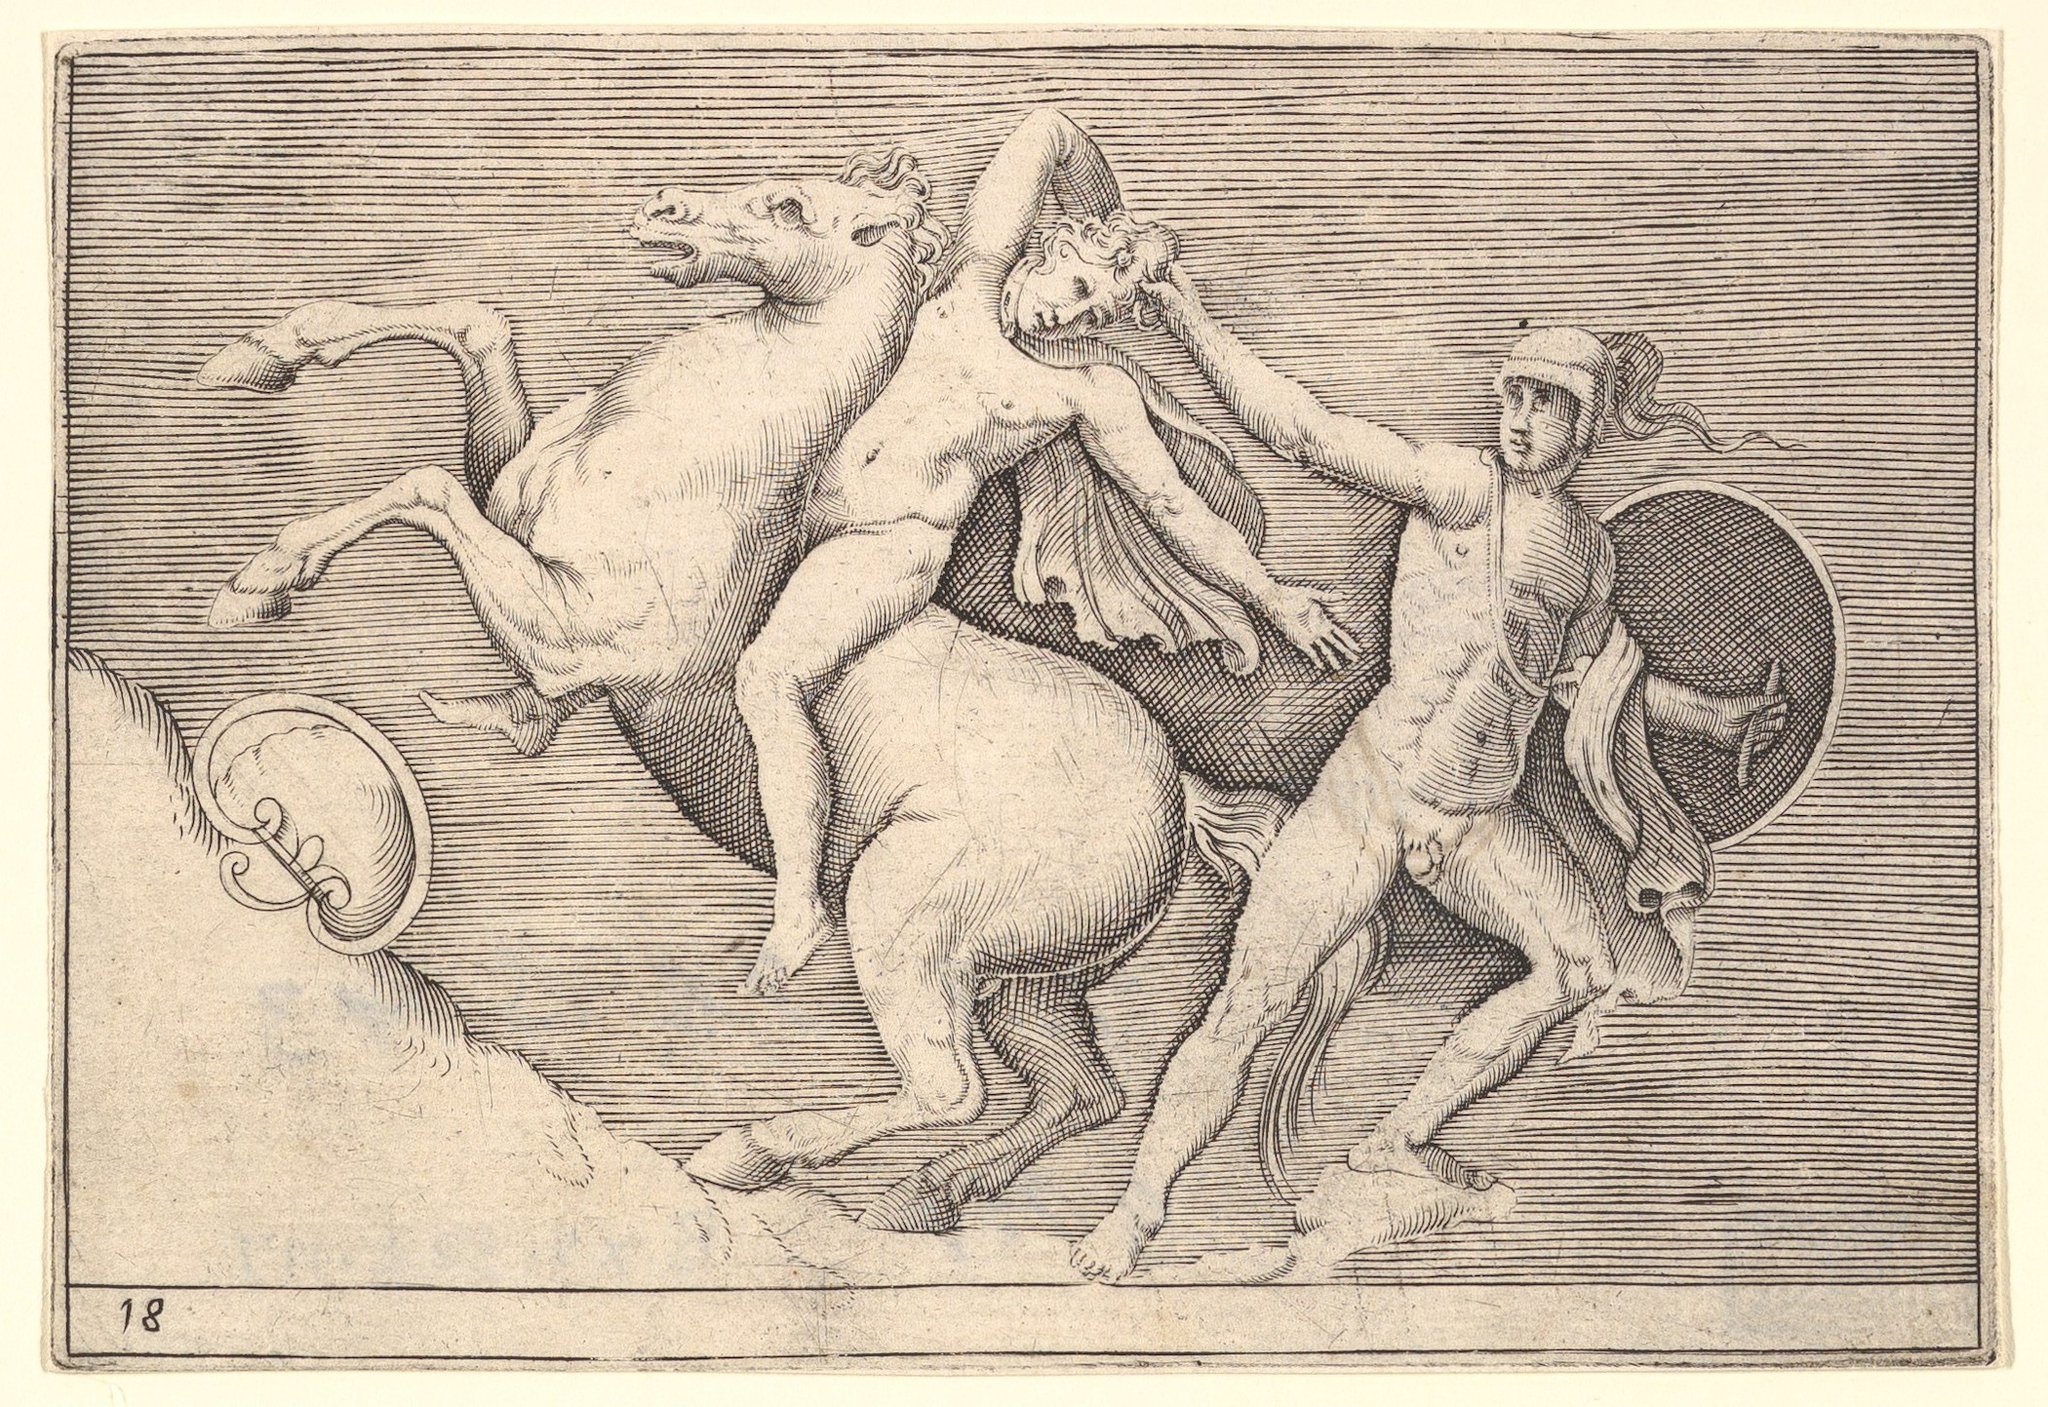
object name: print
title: Warrior Pulling a Rider from His Horse, from "Ex Antiquis Cameorum et Gemmae Delineata/ Liber Secundus/et ab Enea Vico Parmen Incis"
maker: anonymous, italian, 16th century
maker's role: artist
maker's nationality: italian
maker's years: 1500-1600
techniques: engraving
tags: soldiers,shields,male nudes,horses